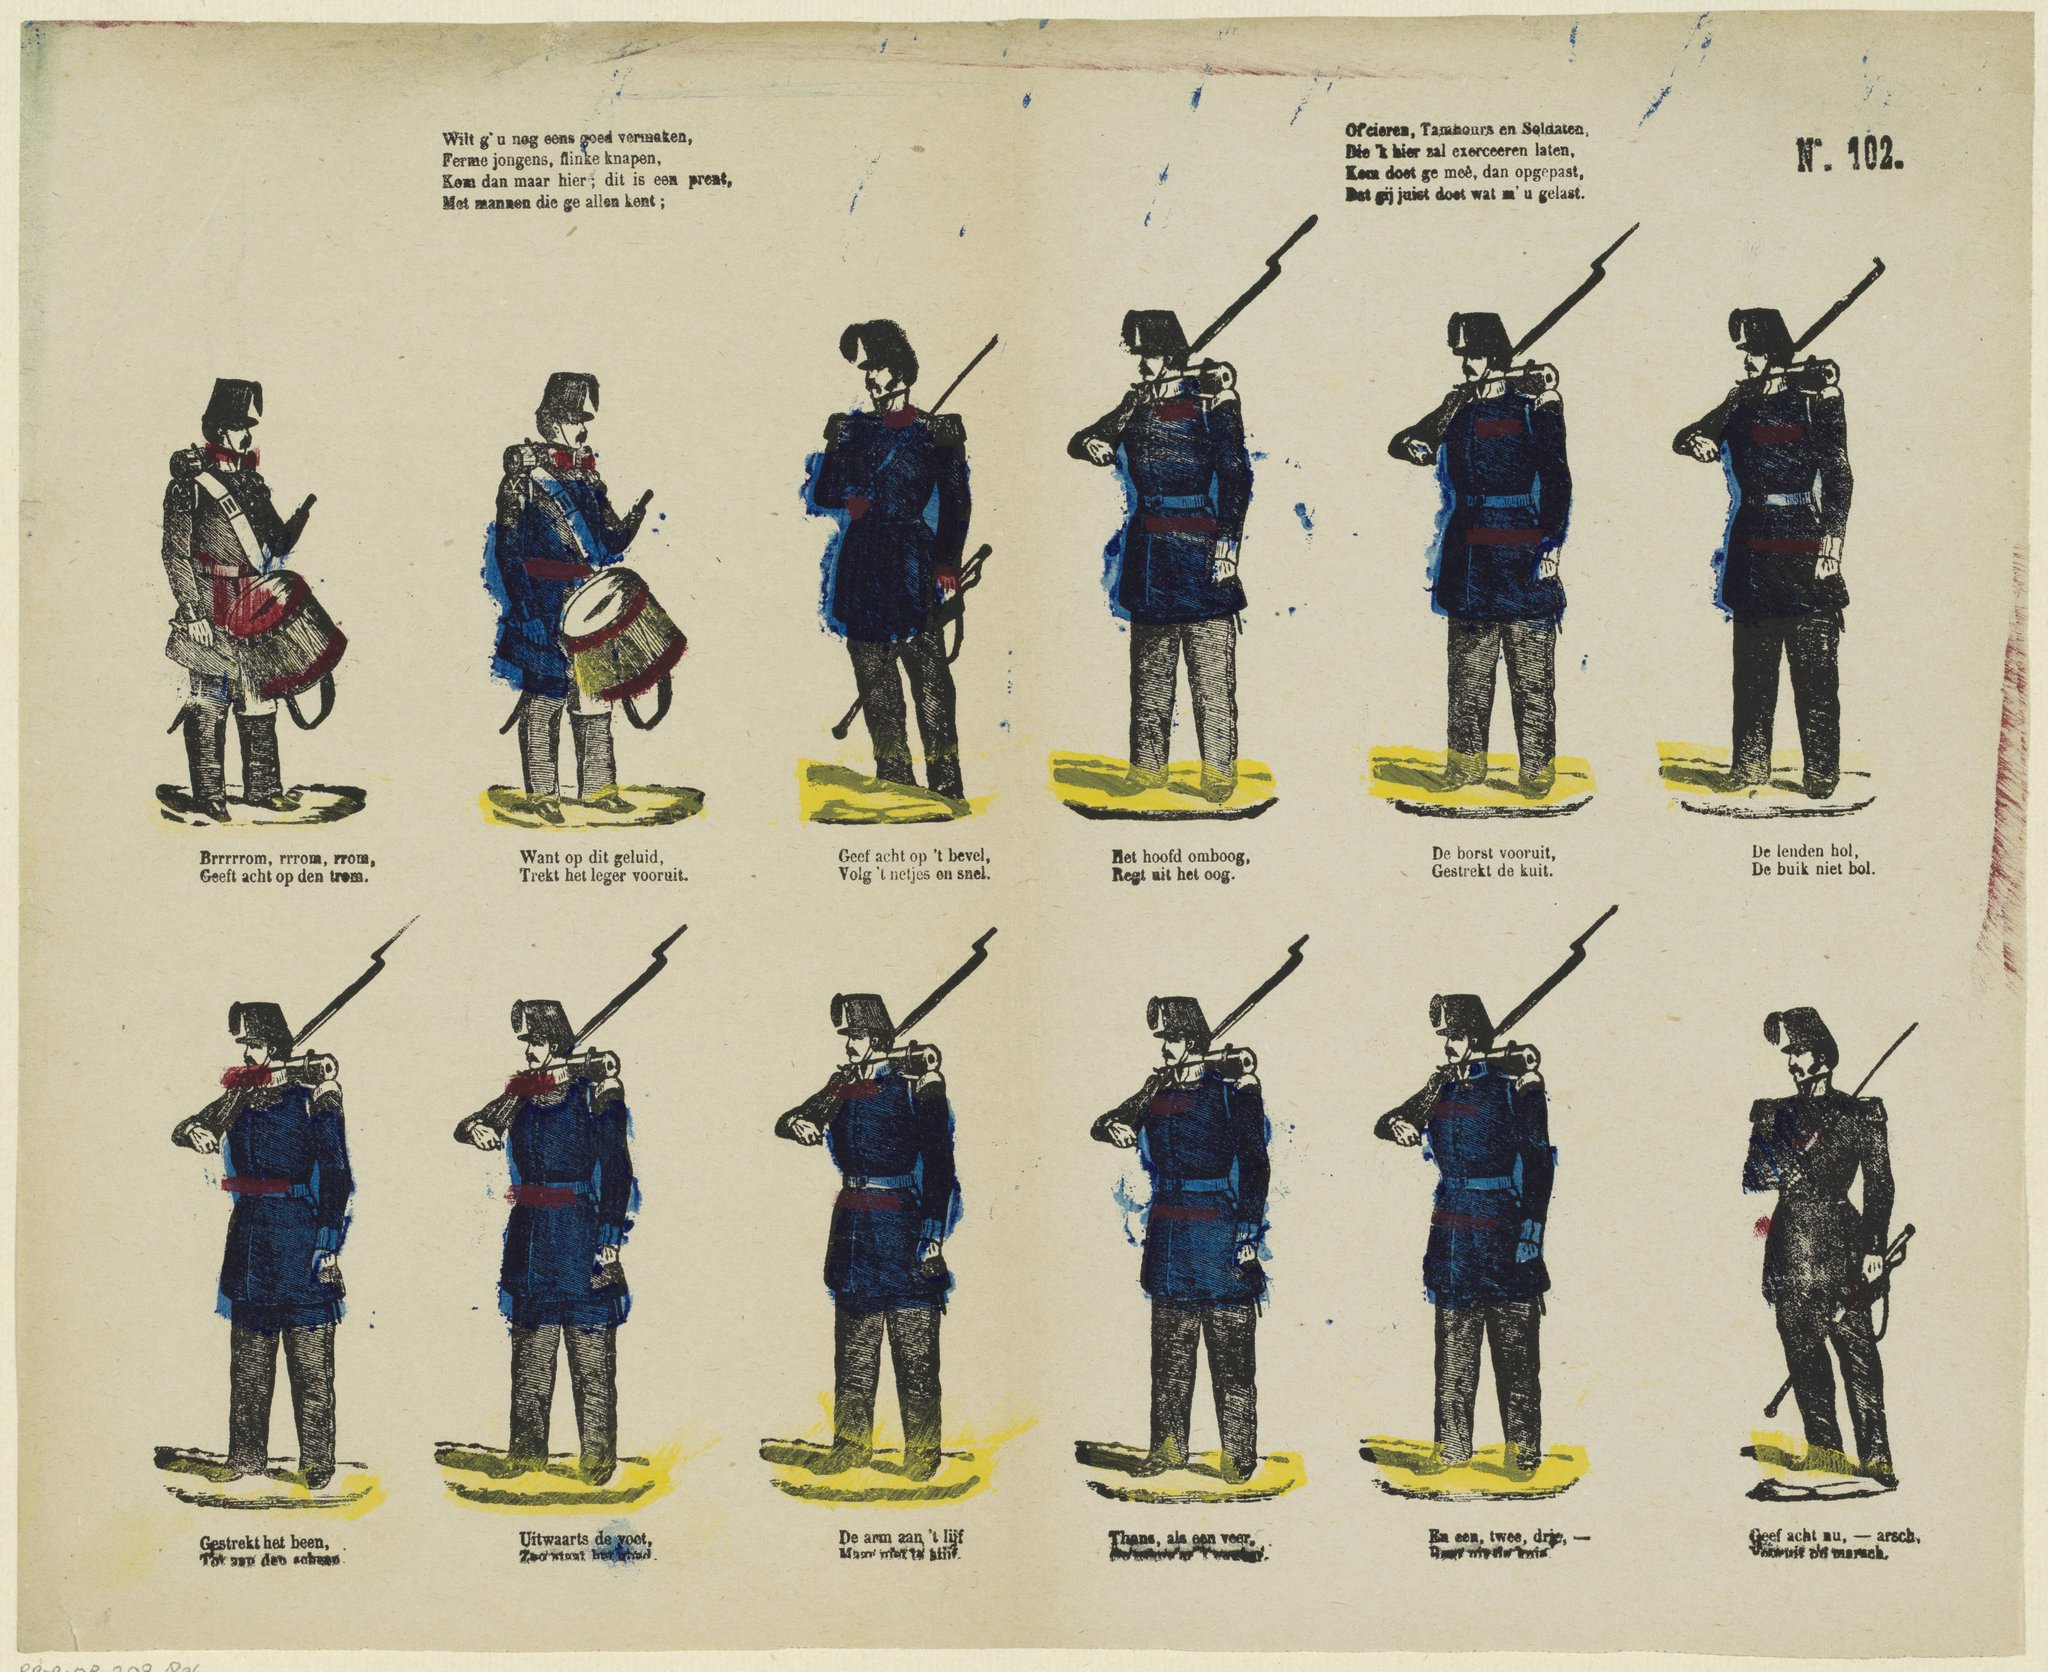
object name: print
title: Wilt g' u nog eens goed vermaken, / Ferme jongens, flinke knapen [(...)]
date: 1827-1894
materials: paper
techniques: colour, letterpress printing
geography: schaarbeek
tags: the soldier; the soldier's life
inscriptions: collector's mark: Lugt 2760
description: Blad met 12 voorstellingen van militairen. Onder elke afbeelding een tweeregelig vers. Genummerd rechtsboven: No. 102.